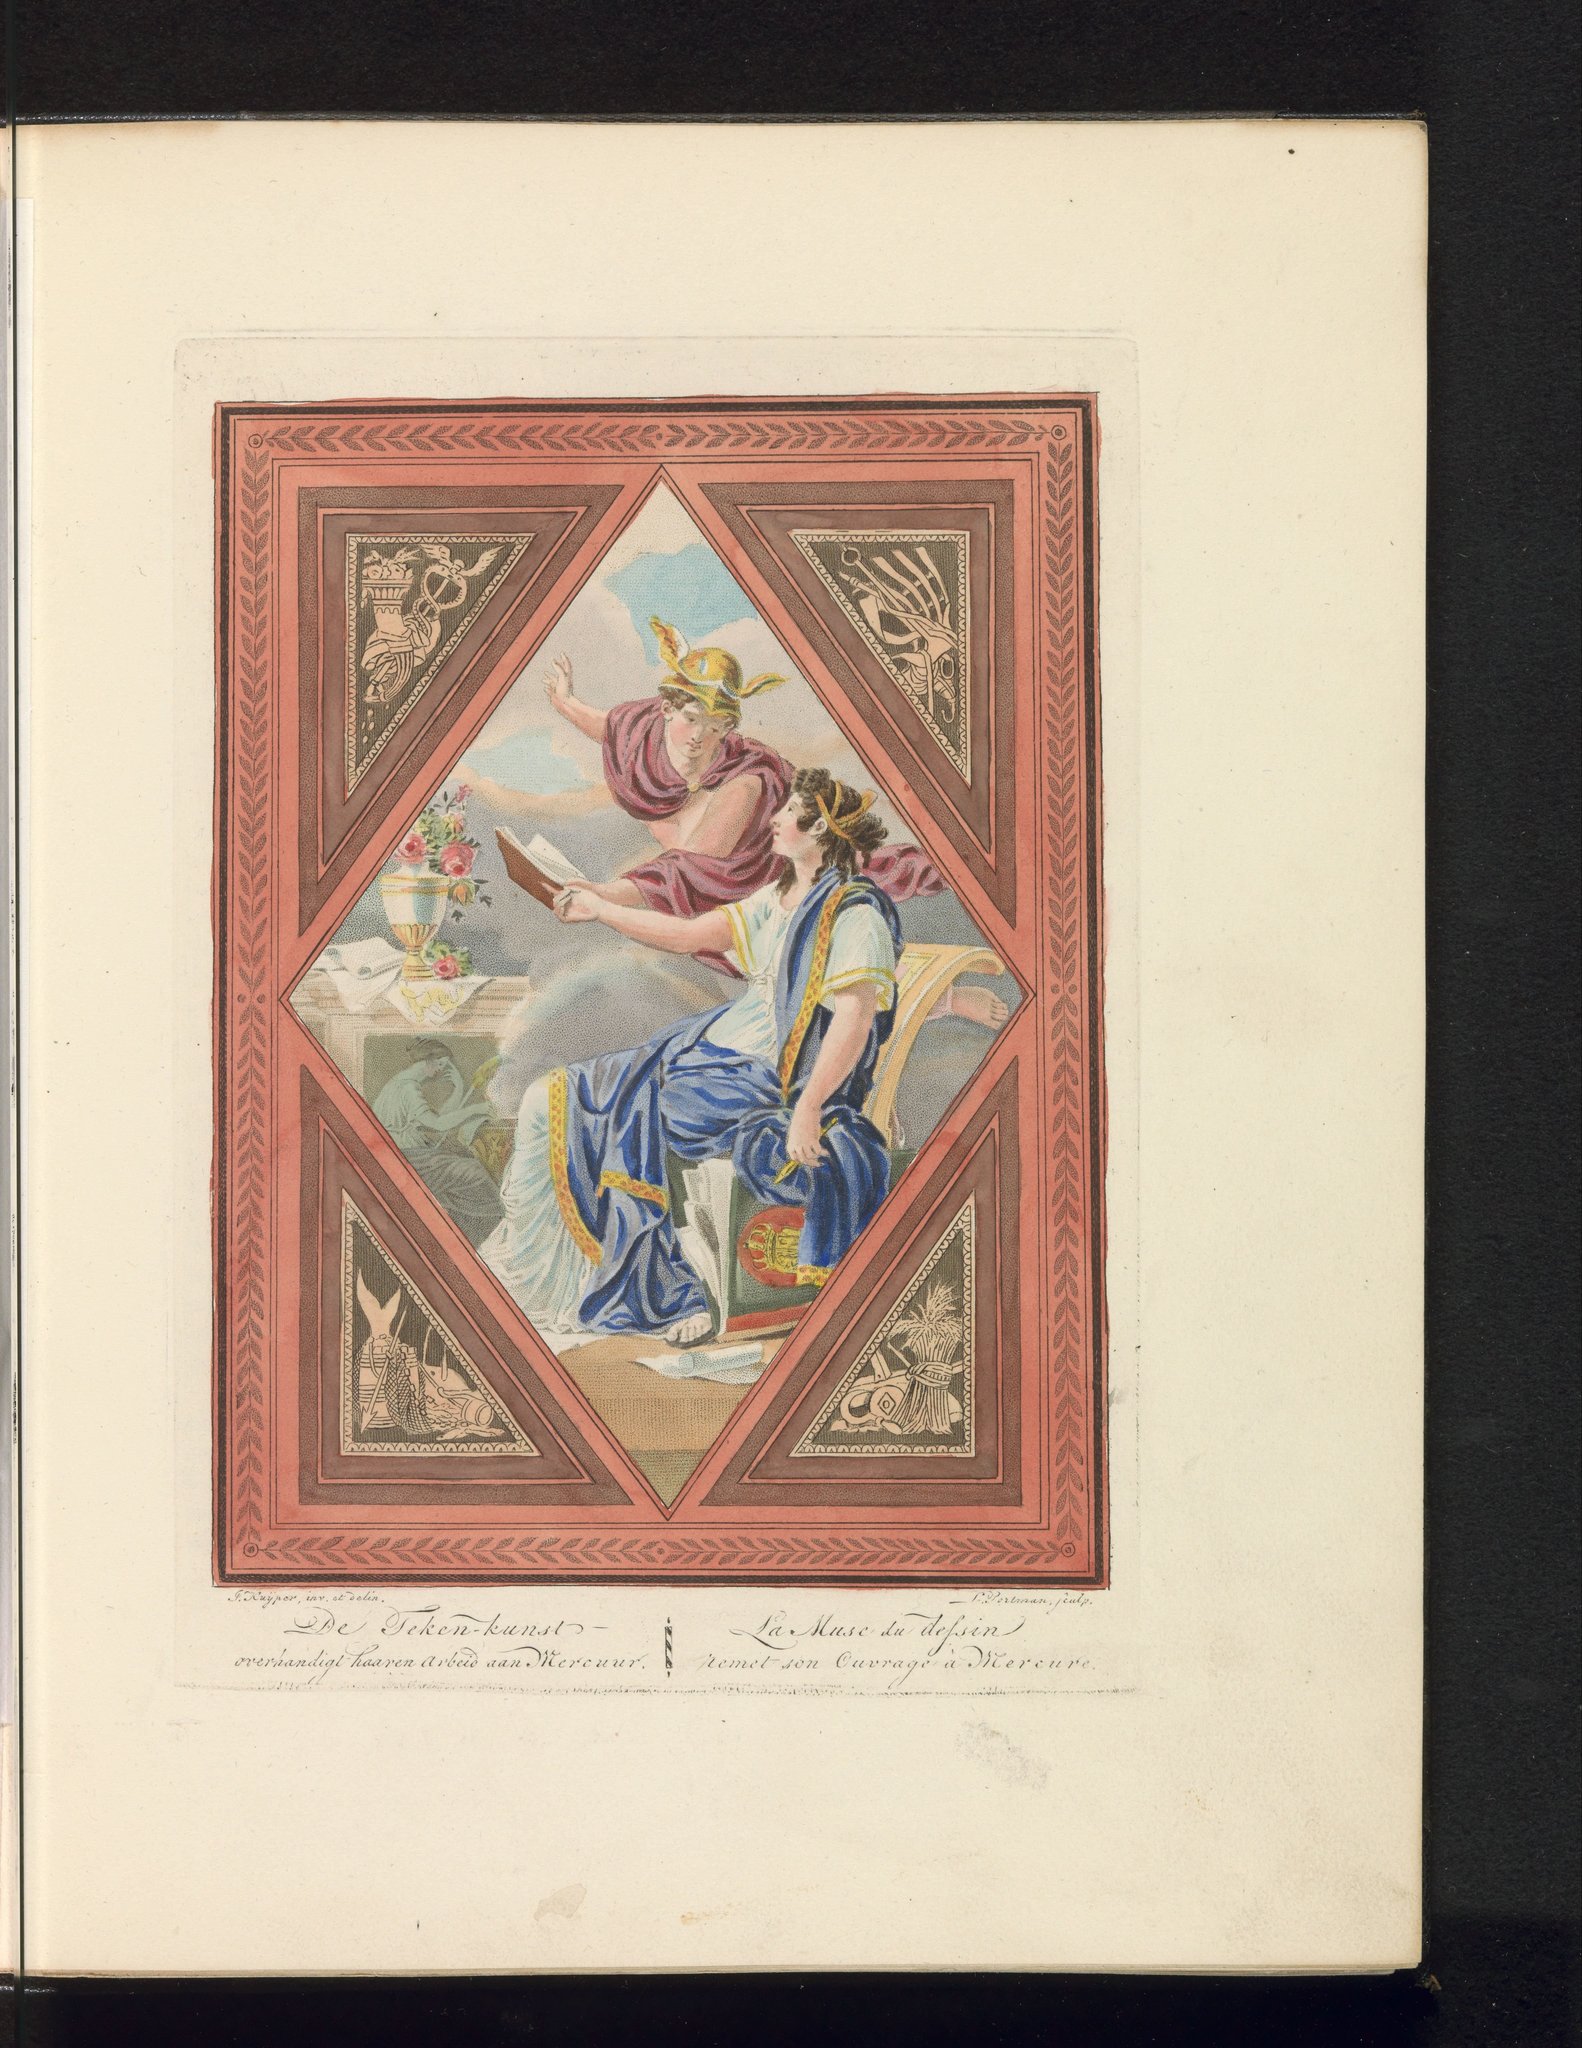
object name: book illustration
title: Tekenkunst toont haar werk aan Mercurius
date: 1805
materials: paper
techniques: etching, hand coloring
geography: amsterdam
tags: symbolic representations, allegories and emblems ~ drawing, specific aspects, allegorical aspects of mercury; mercury as patron - veneration, honoured by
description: Gebruikt als illustratie in: Evert Maaskamp, Afbeeldingen van de kleedingen, zeden en gewoonten in de noordelijke provincien van het Koningrijk der Nederlanden, met den aanvang der negentiende eeuw = Tableaux des habillemens, mœurs et coutumes dans les provinces septentrionales du Royaume des Pays-Bas, au commencement du dix-neuvième siècle. Amsterdam: Evert Maaskamp, 1829 [heruitgave van de oorspronkelijke platen eerst verschenen in 1803-1807].